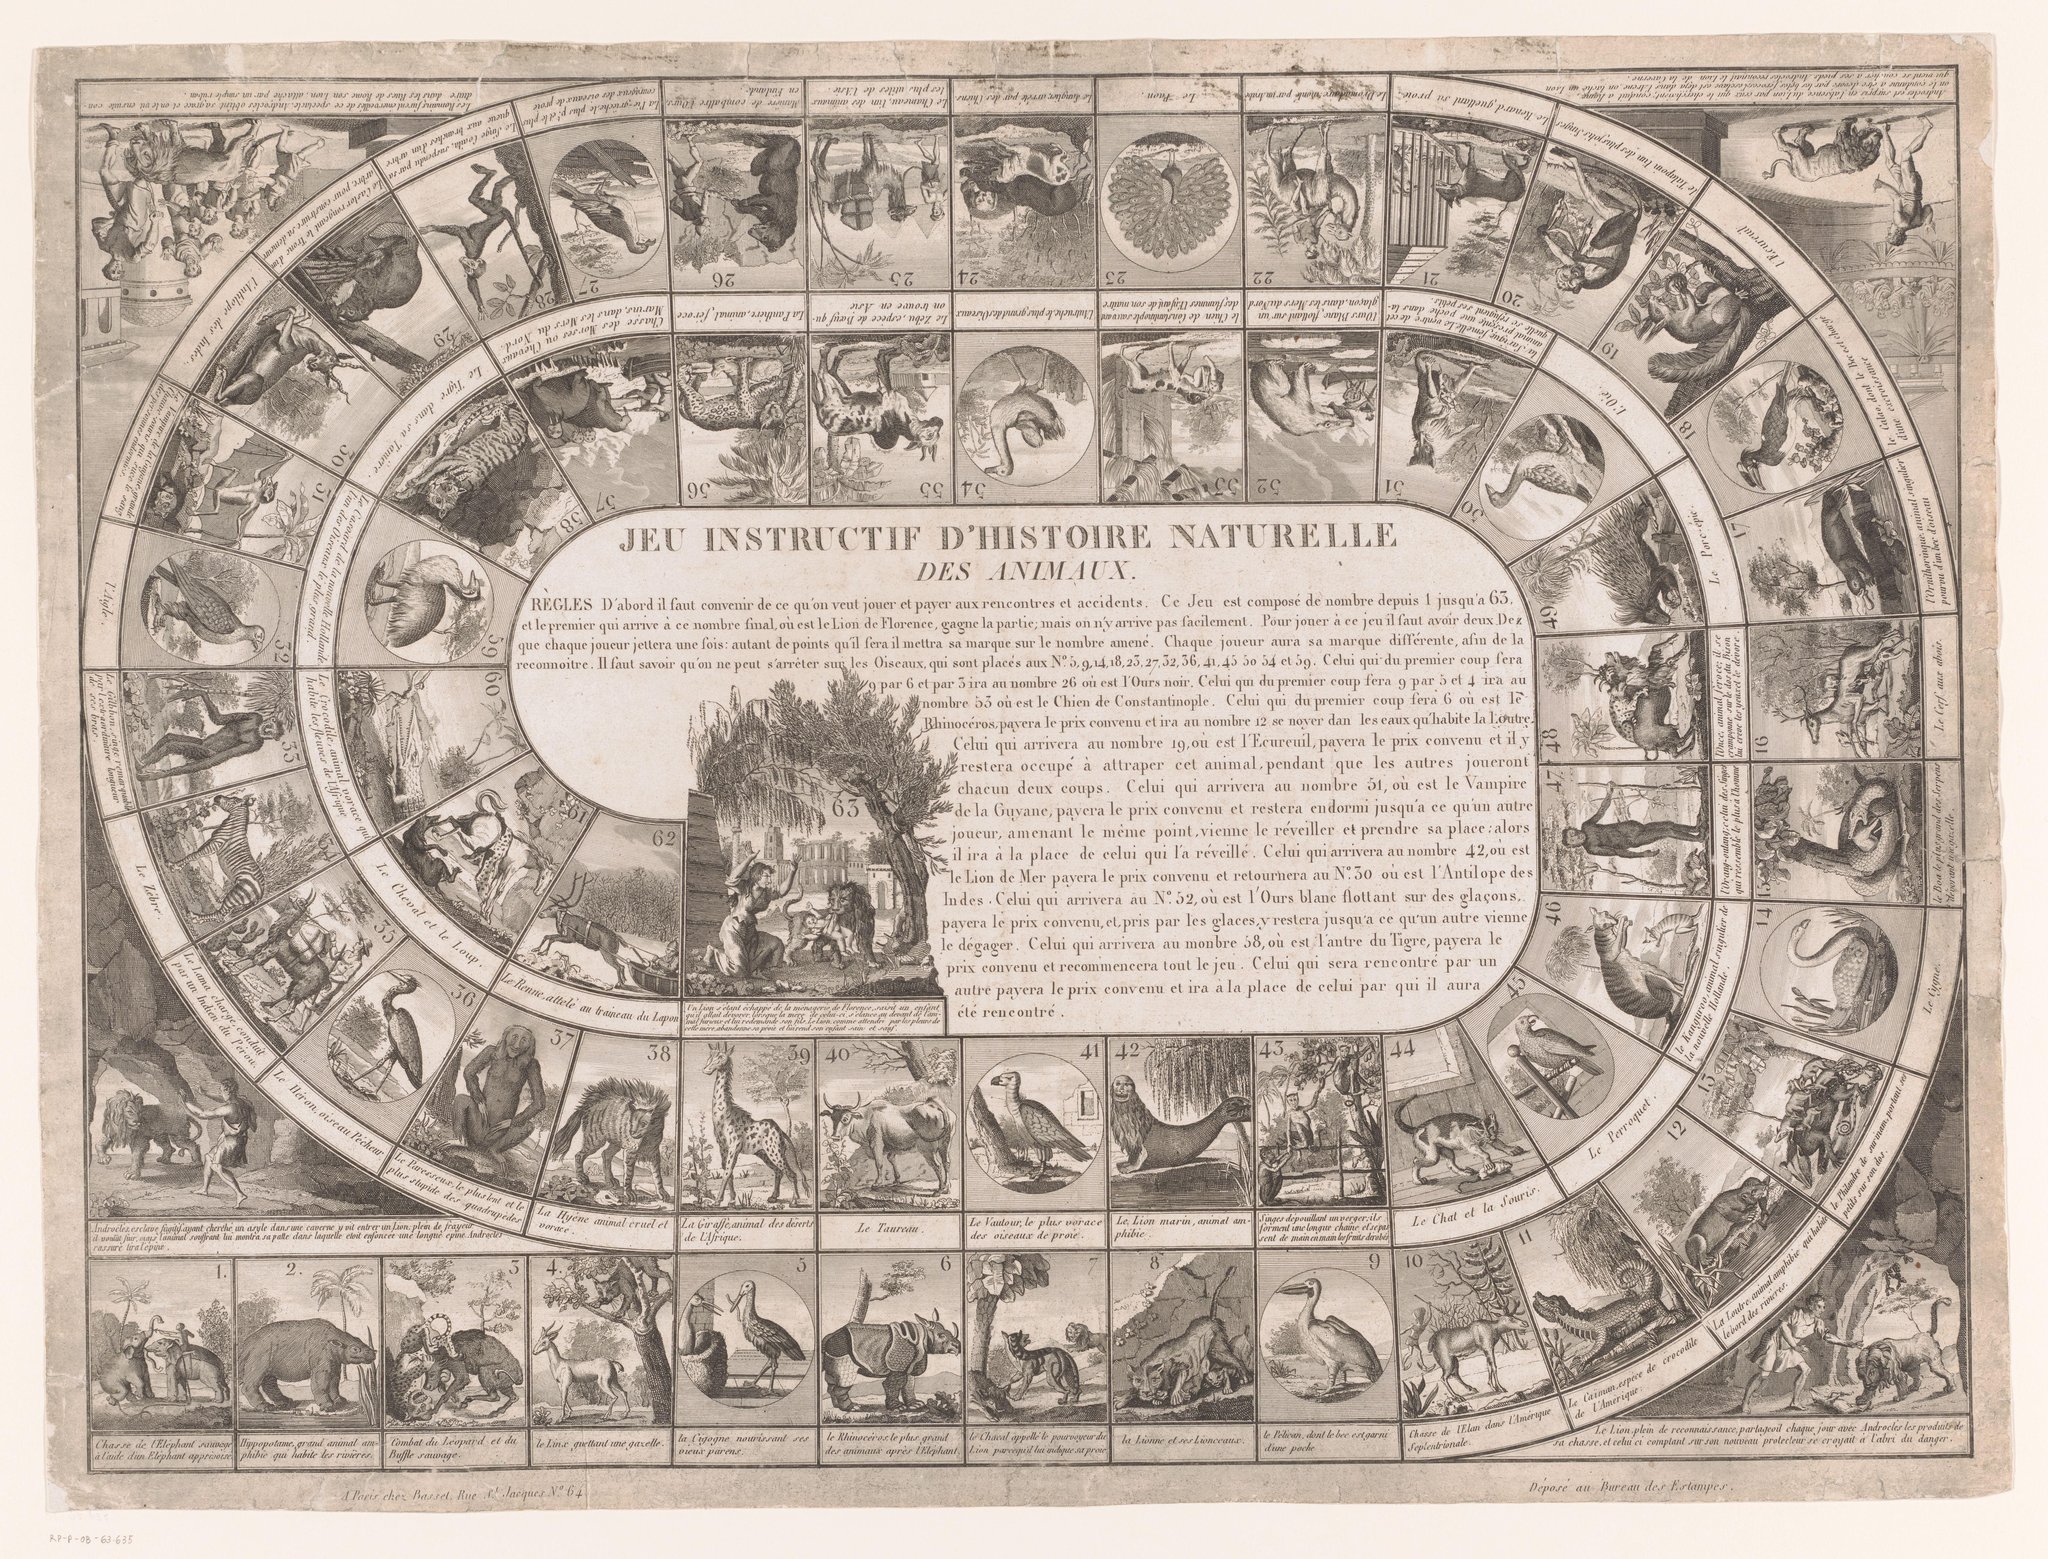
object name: print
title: Ganzenbord met diervoorstellingen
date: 1600-1699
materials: paper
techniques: etching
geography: france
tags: goose-game, animals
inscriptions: collector's mark: Lugt 2228, : ‘Déposé au Bureau des Estampes’